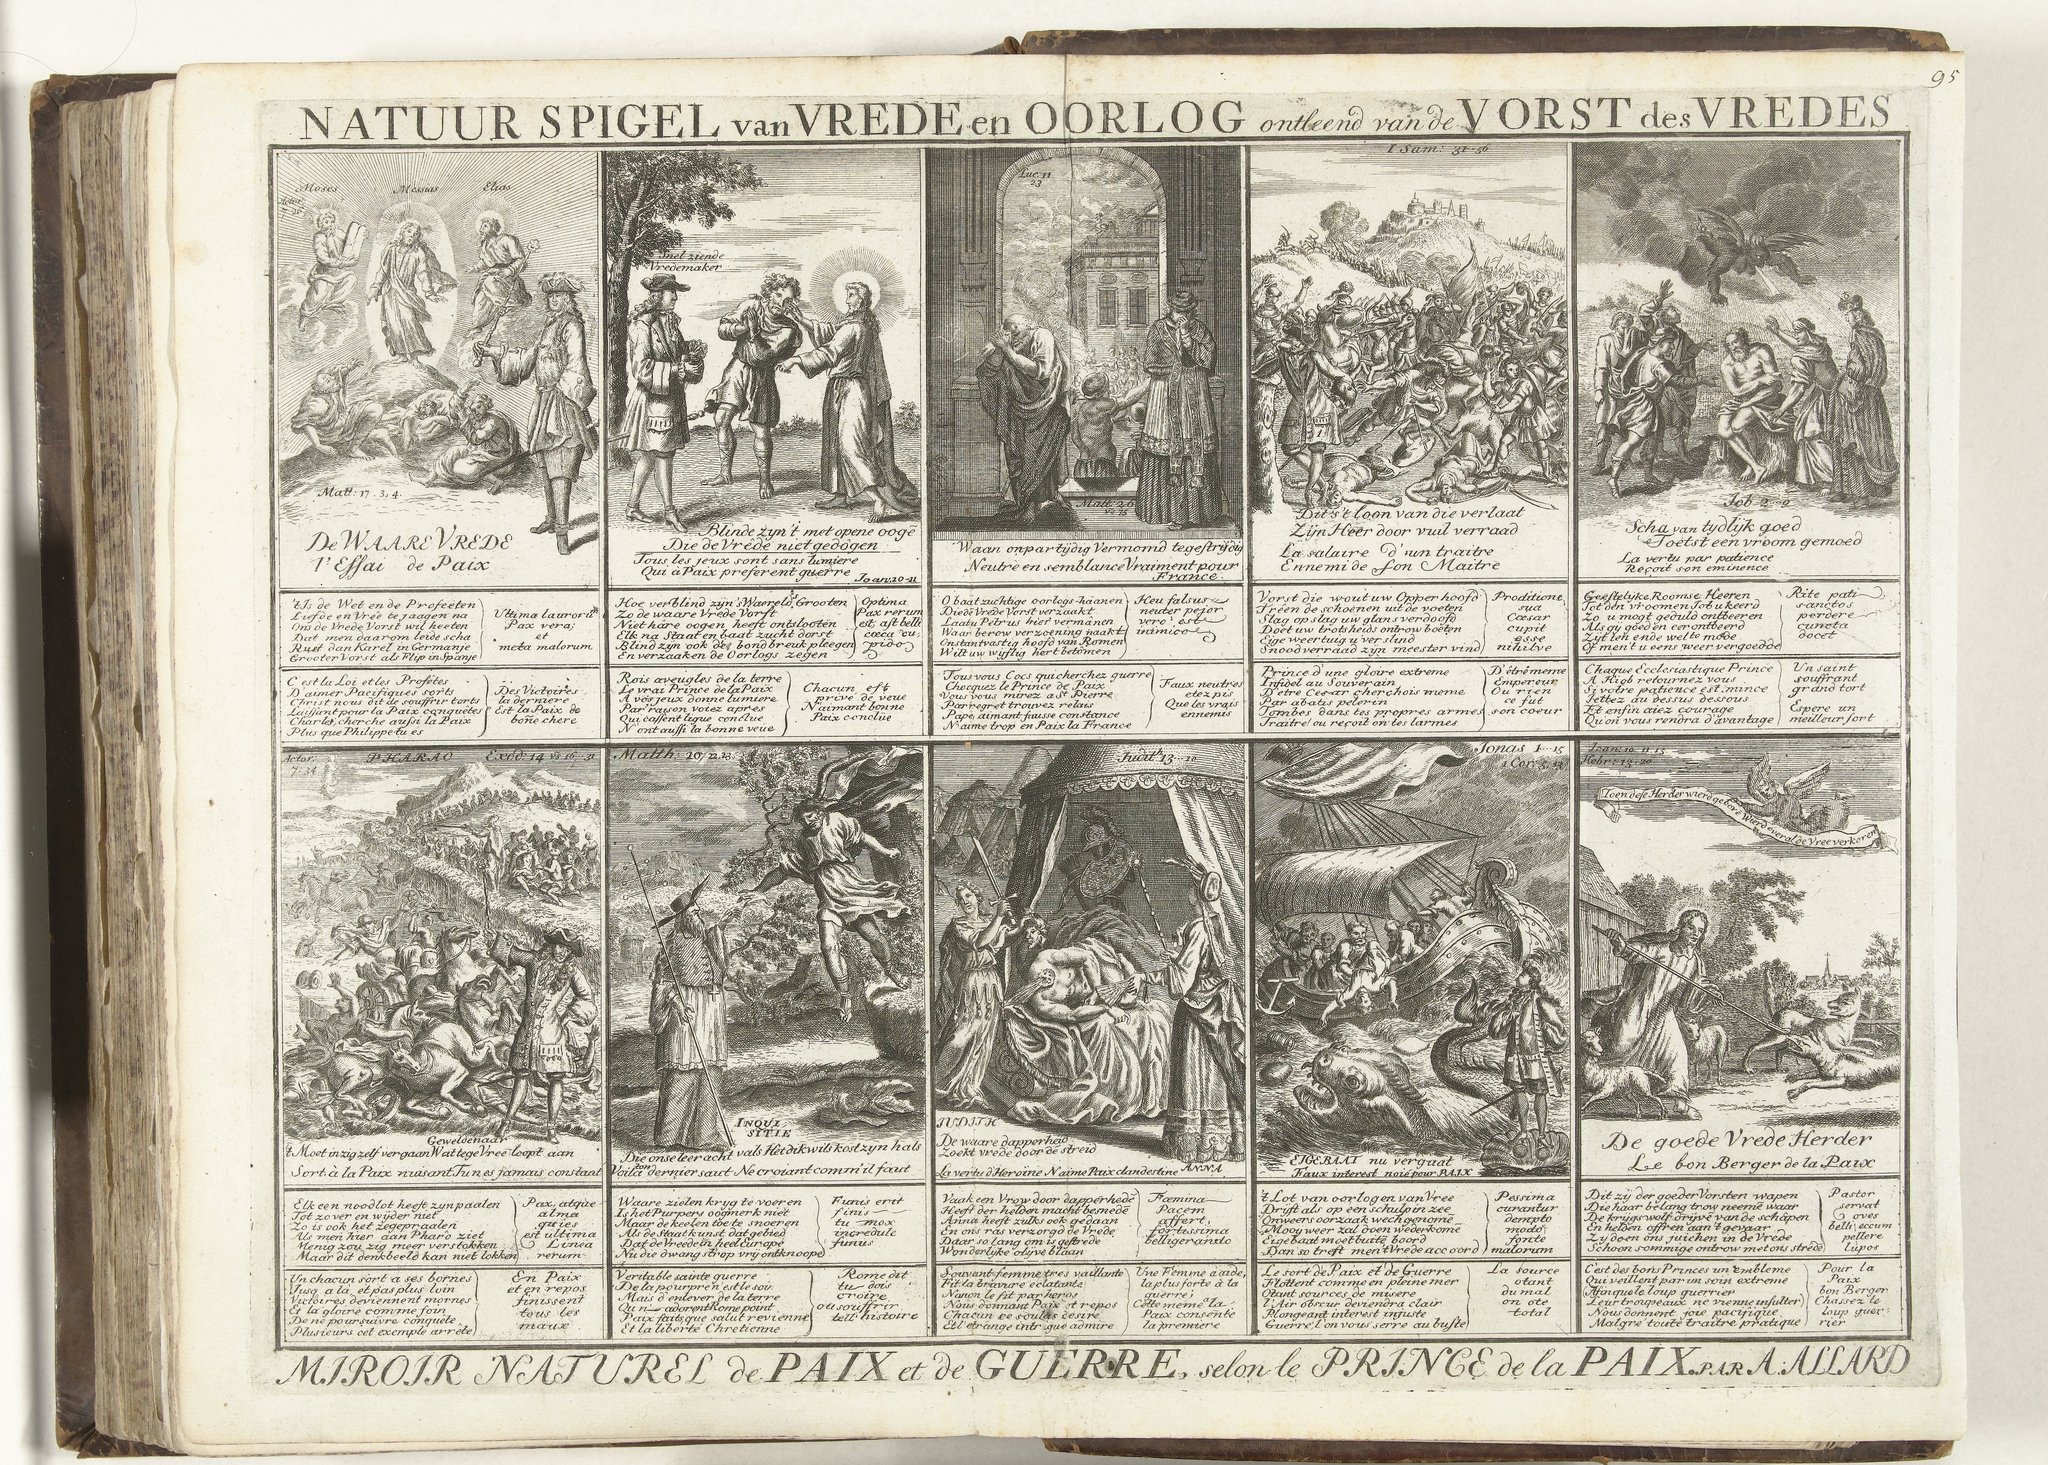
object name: print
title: Platen over de Vrede van Utrecht van 1713 / 't Lusthof van Momus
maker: abraham allard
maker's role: print maker, publisher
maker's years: 1676-1725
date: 1713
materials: paper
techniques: etching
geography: amsterdam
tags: vrede van utrecht (1713)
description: Natuurlijke Spiegel van Oorlog en Vrede. Blad met tien voorstellingen met een vermenging van bijbelse verhalen en politieke allegorieën in verband met de Vrede van Utrecht, 1713. In de plaat verzen in het Nederlands en Frans. Onderdeel van een groep van 28 nieuwe en oude platen aangepast ter illustratie van de Vrede van Utrecht in 1713. Onderdeel van het prentwerk uitgegeven onder de verzameltitel 't Lust-Hof van Momus met de gebundelde series van spotprenten tijdens de jaren 1701-1713 van de Spaanse Successieoorlog.